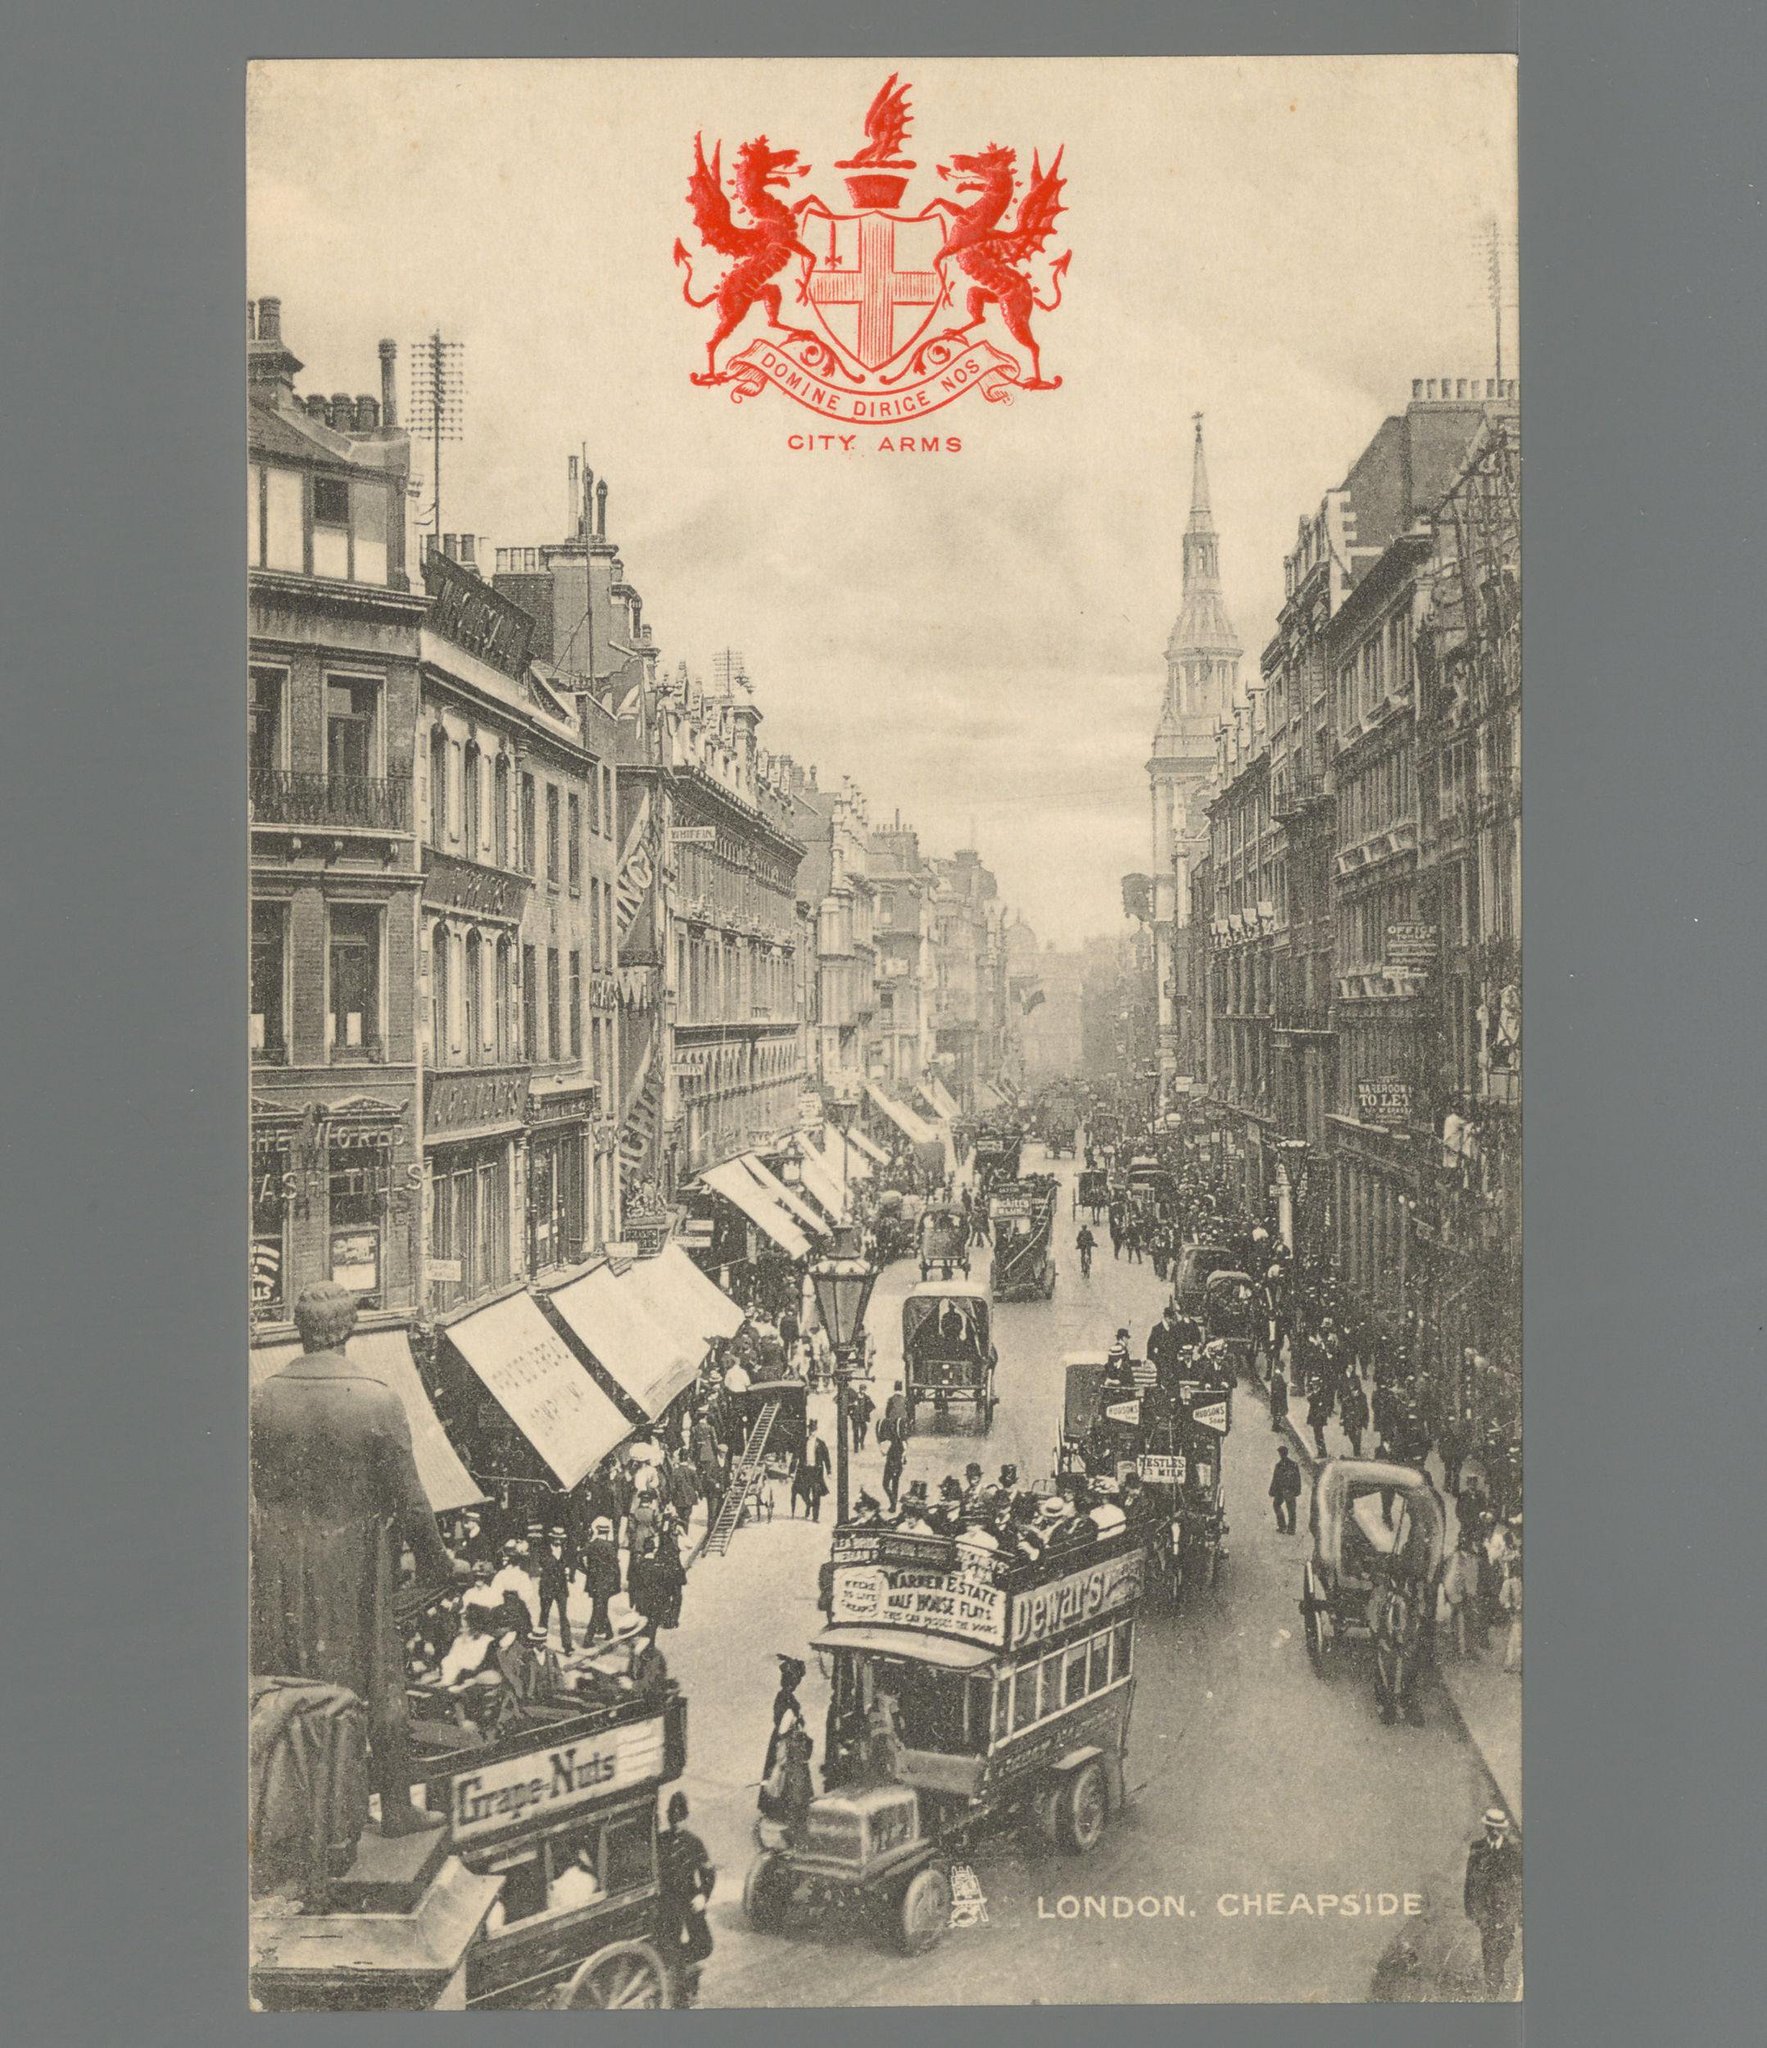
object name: ansichtkaart, prentbriefkaart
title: London. Cheapside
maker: Anonymous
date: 1906-1912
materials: cardboard, lacquer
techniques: blind stamped, photograph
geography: london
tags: diligence, omnibus, horse-tram, automobile, street, london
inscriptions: check stamp